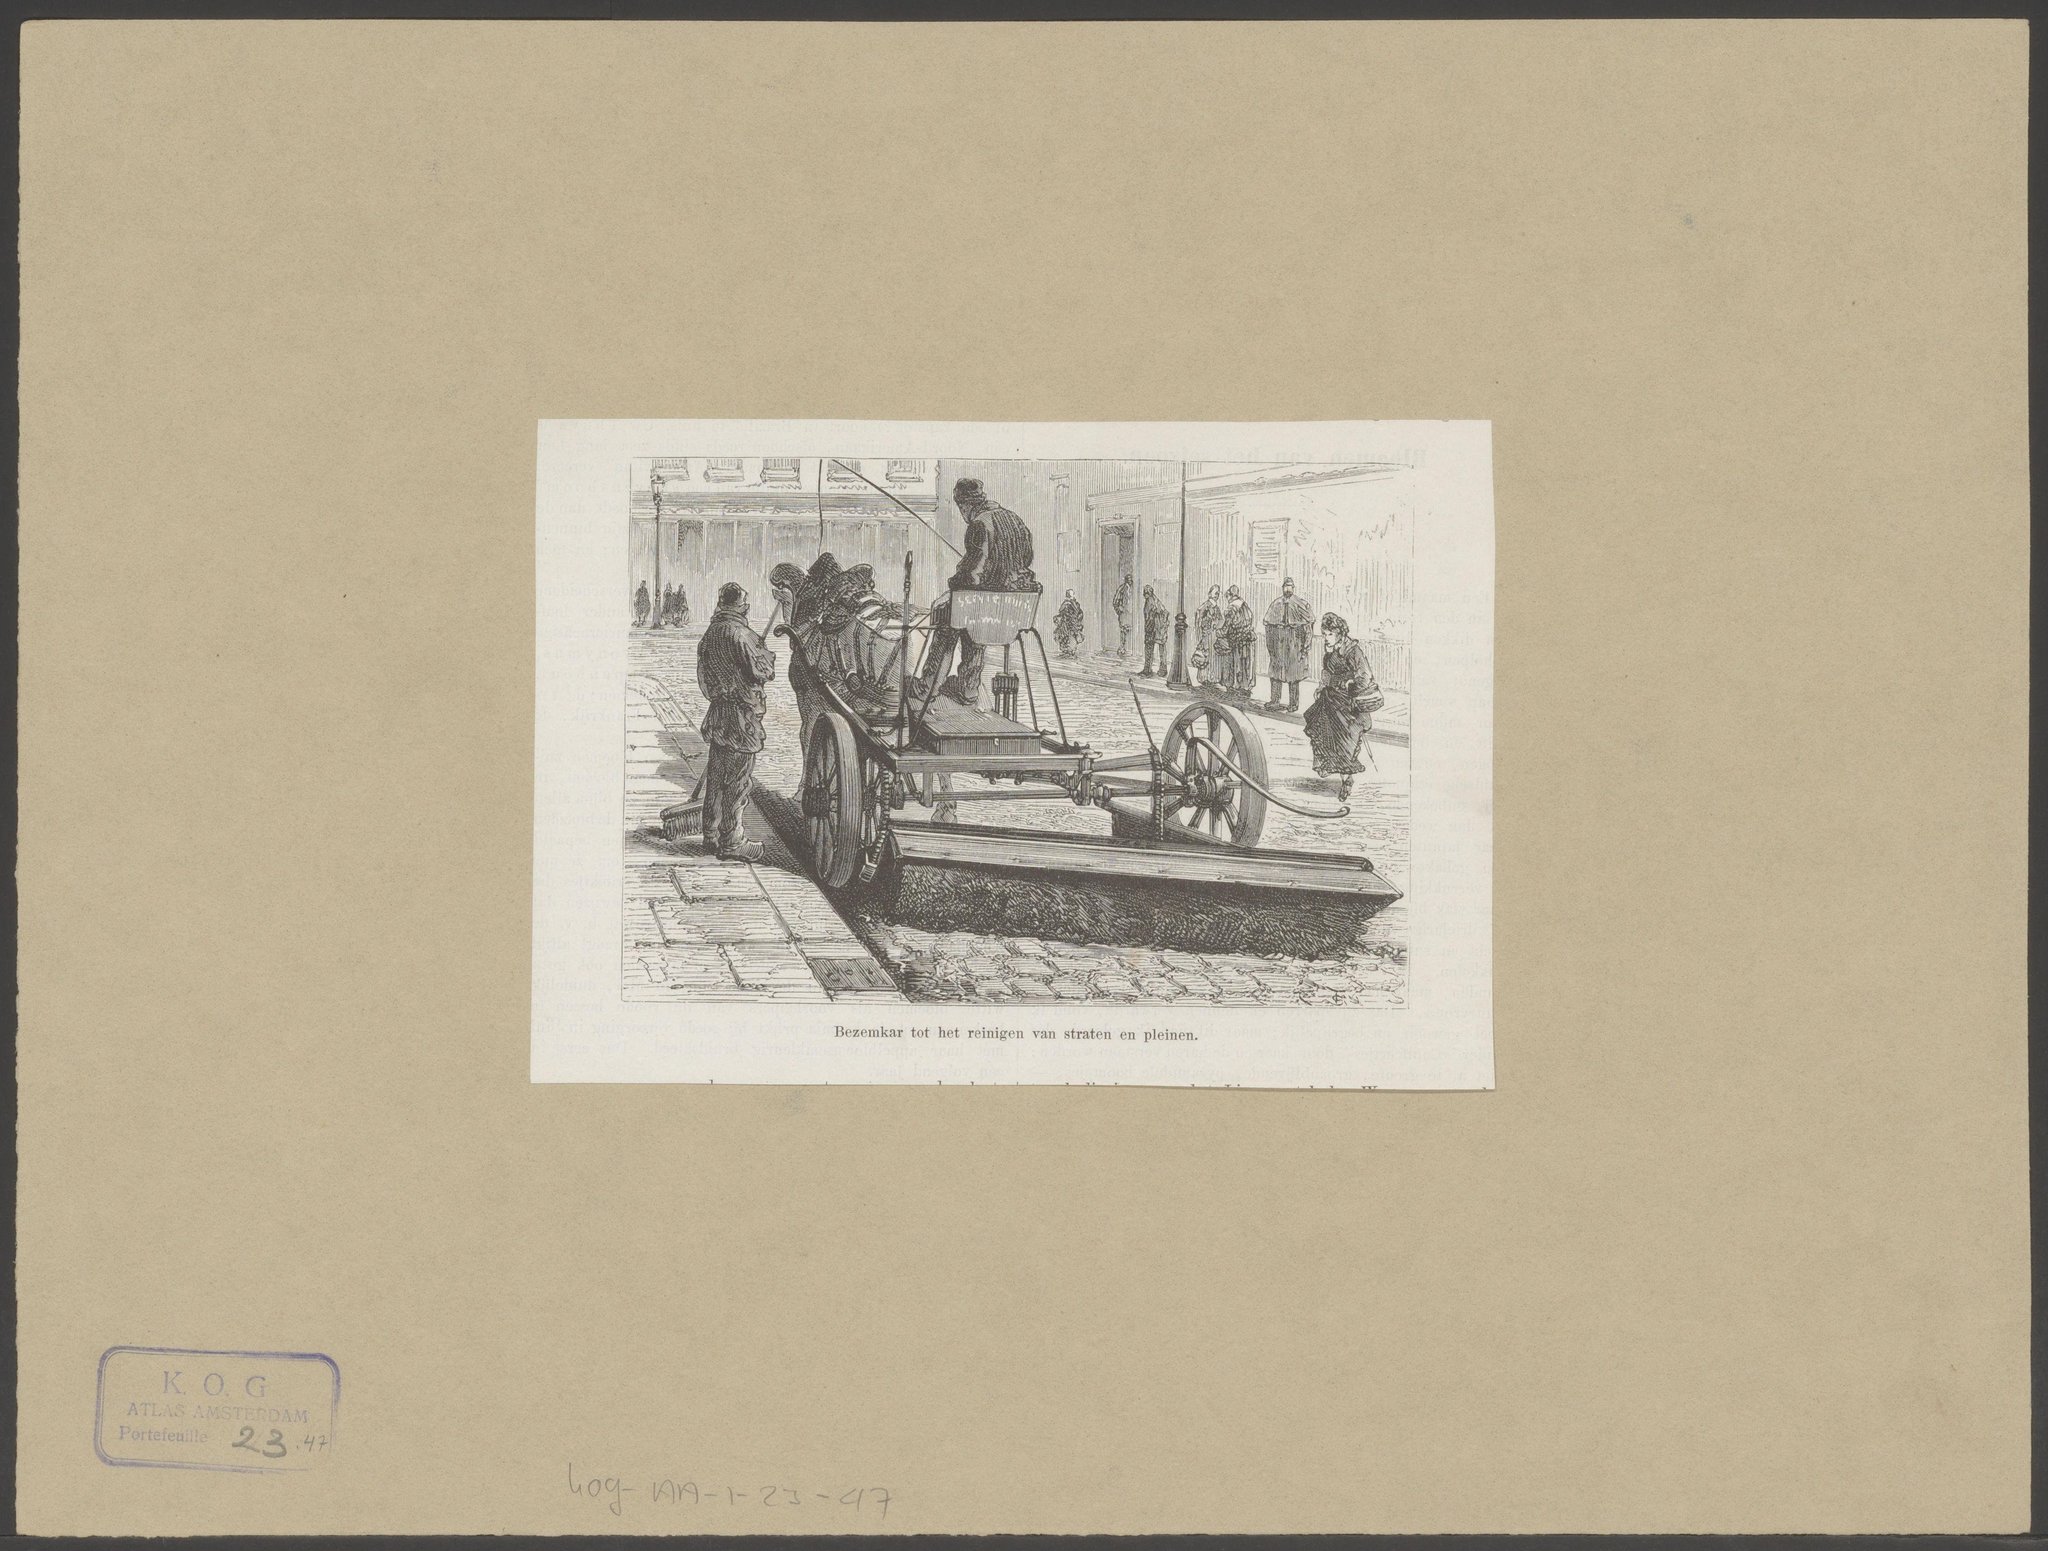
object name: print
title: Straatveger getrokken door een paard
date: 1878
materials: paper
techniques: letterpress printing, engraving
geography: haarlem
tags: street sweeping, street sweeper, two-wheeled vehicle drawn by one animal, amsterdam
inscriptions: monogram: ‘TS (?)’, collector's mark: Lugt 1641b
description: Prent uit: Eigen Haard 4 (1878), nr. 52, 28 december 1878, p. 503.